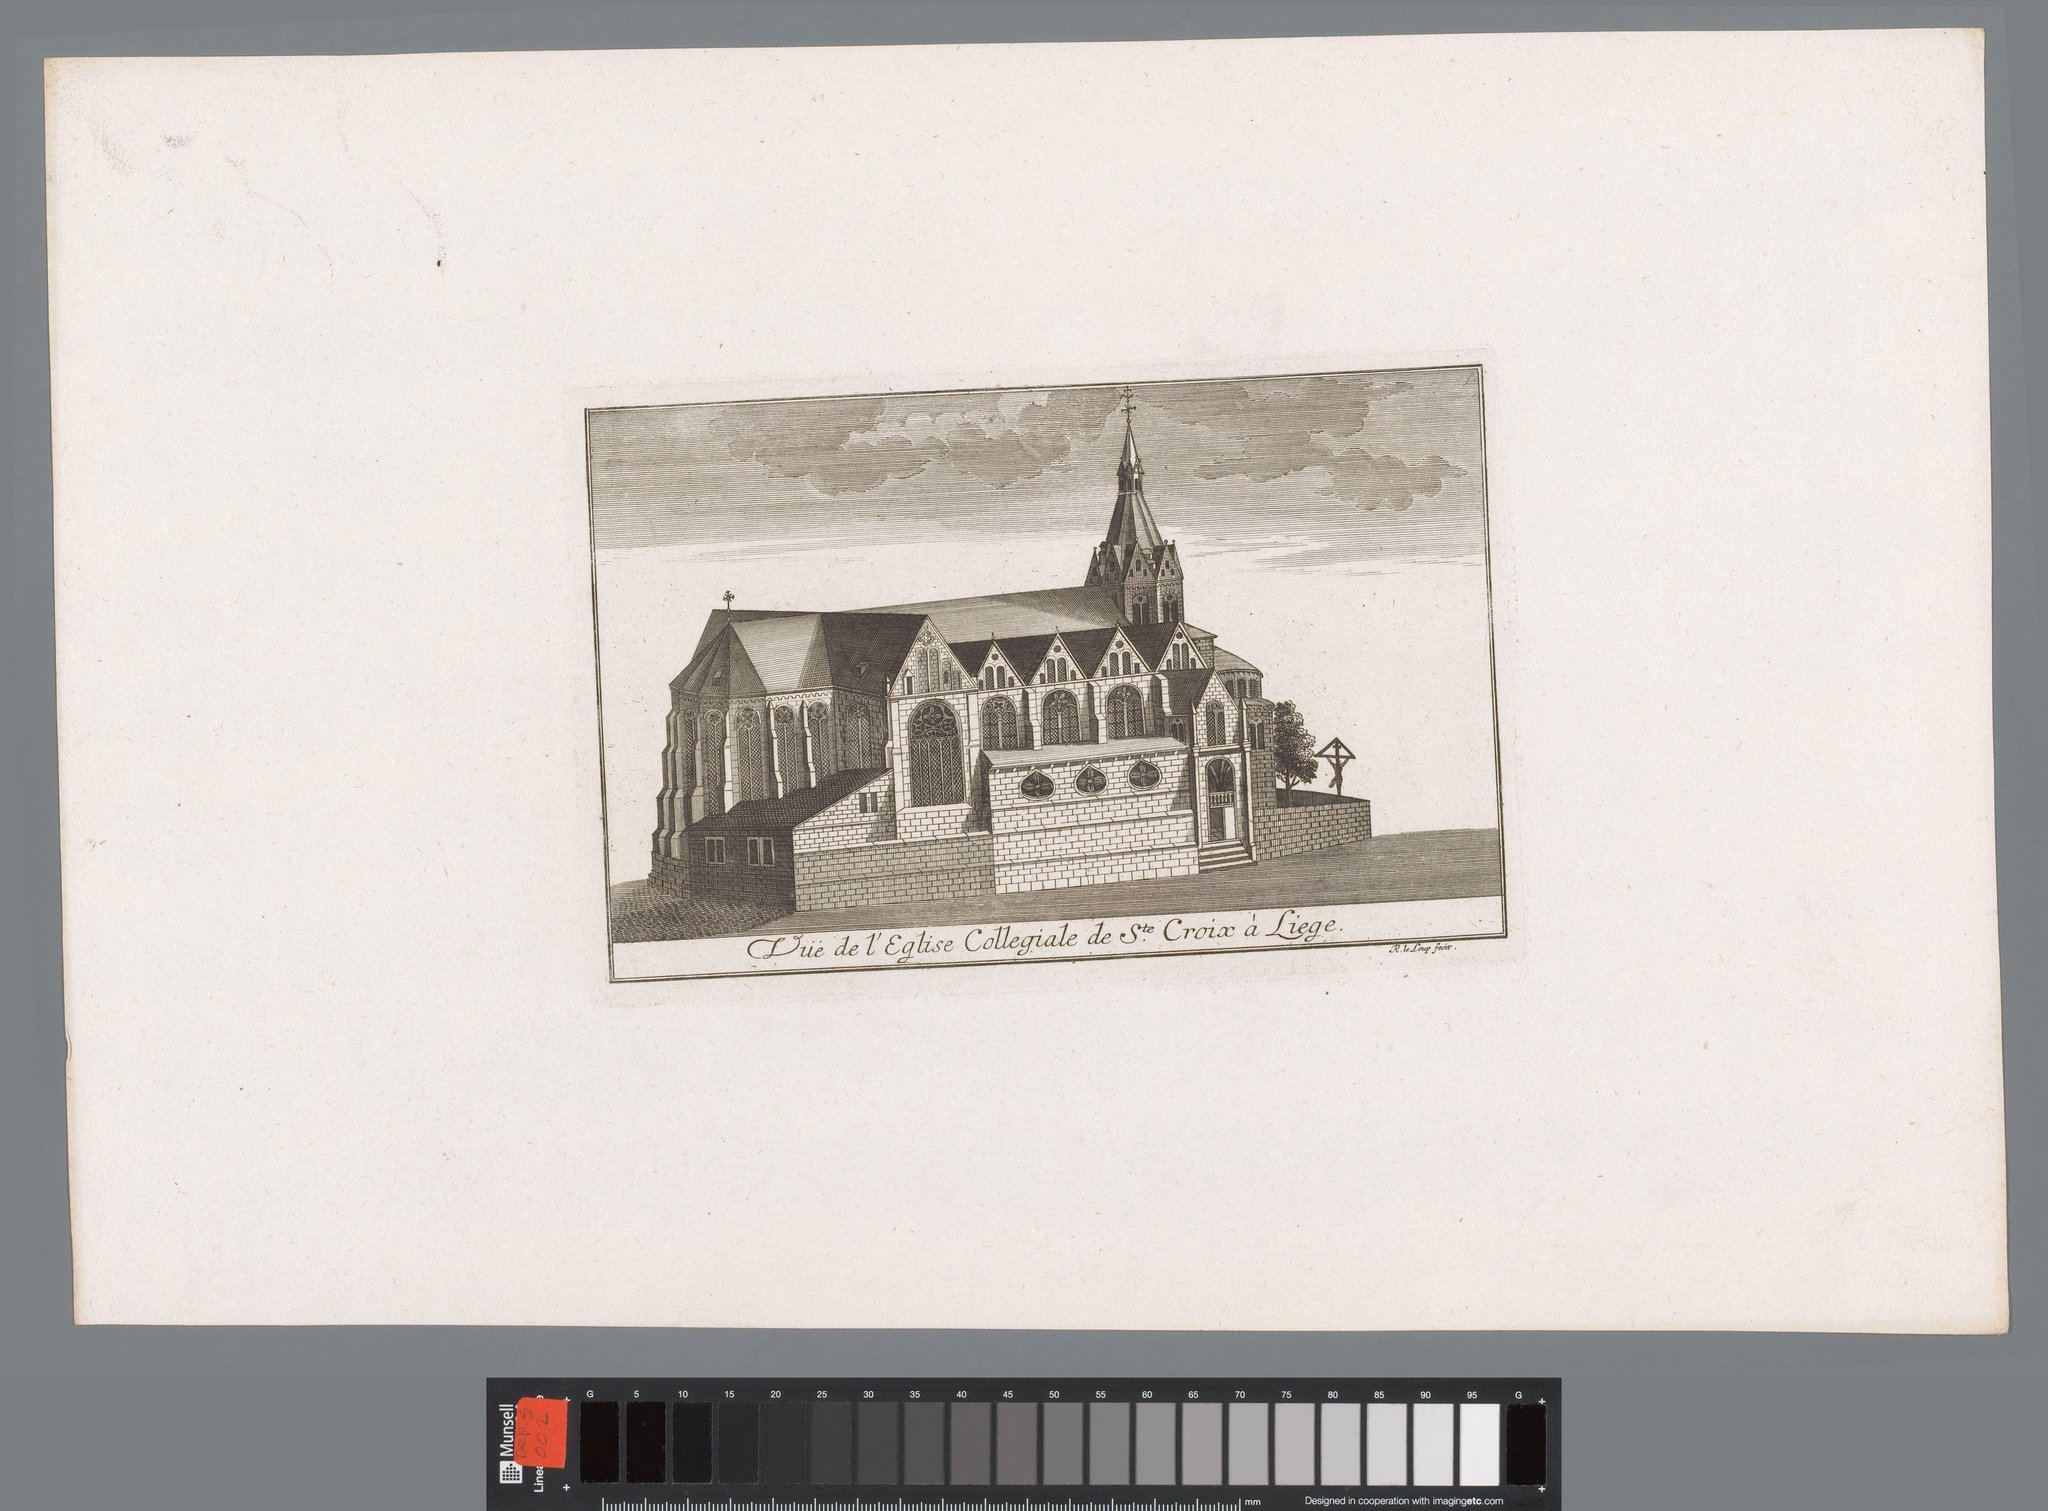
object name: print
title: Vüe de l'Eglise Collegiale de Ste. Croix à Liege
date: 1738-1744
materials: paper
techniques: engraving, etching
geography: liège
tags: church (exterior), liège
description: Prent uit: Johanne de Saumery, Alexandre de et al. Les délices du païs de Liège, ou description géographique, topographique et chorographique des monumes sacrés et profanes (...). 5 dln. Luik: Everard Kints, 1738-1744, dl. 1, p. 133.